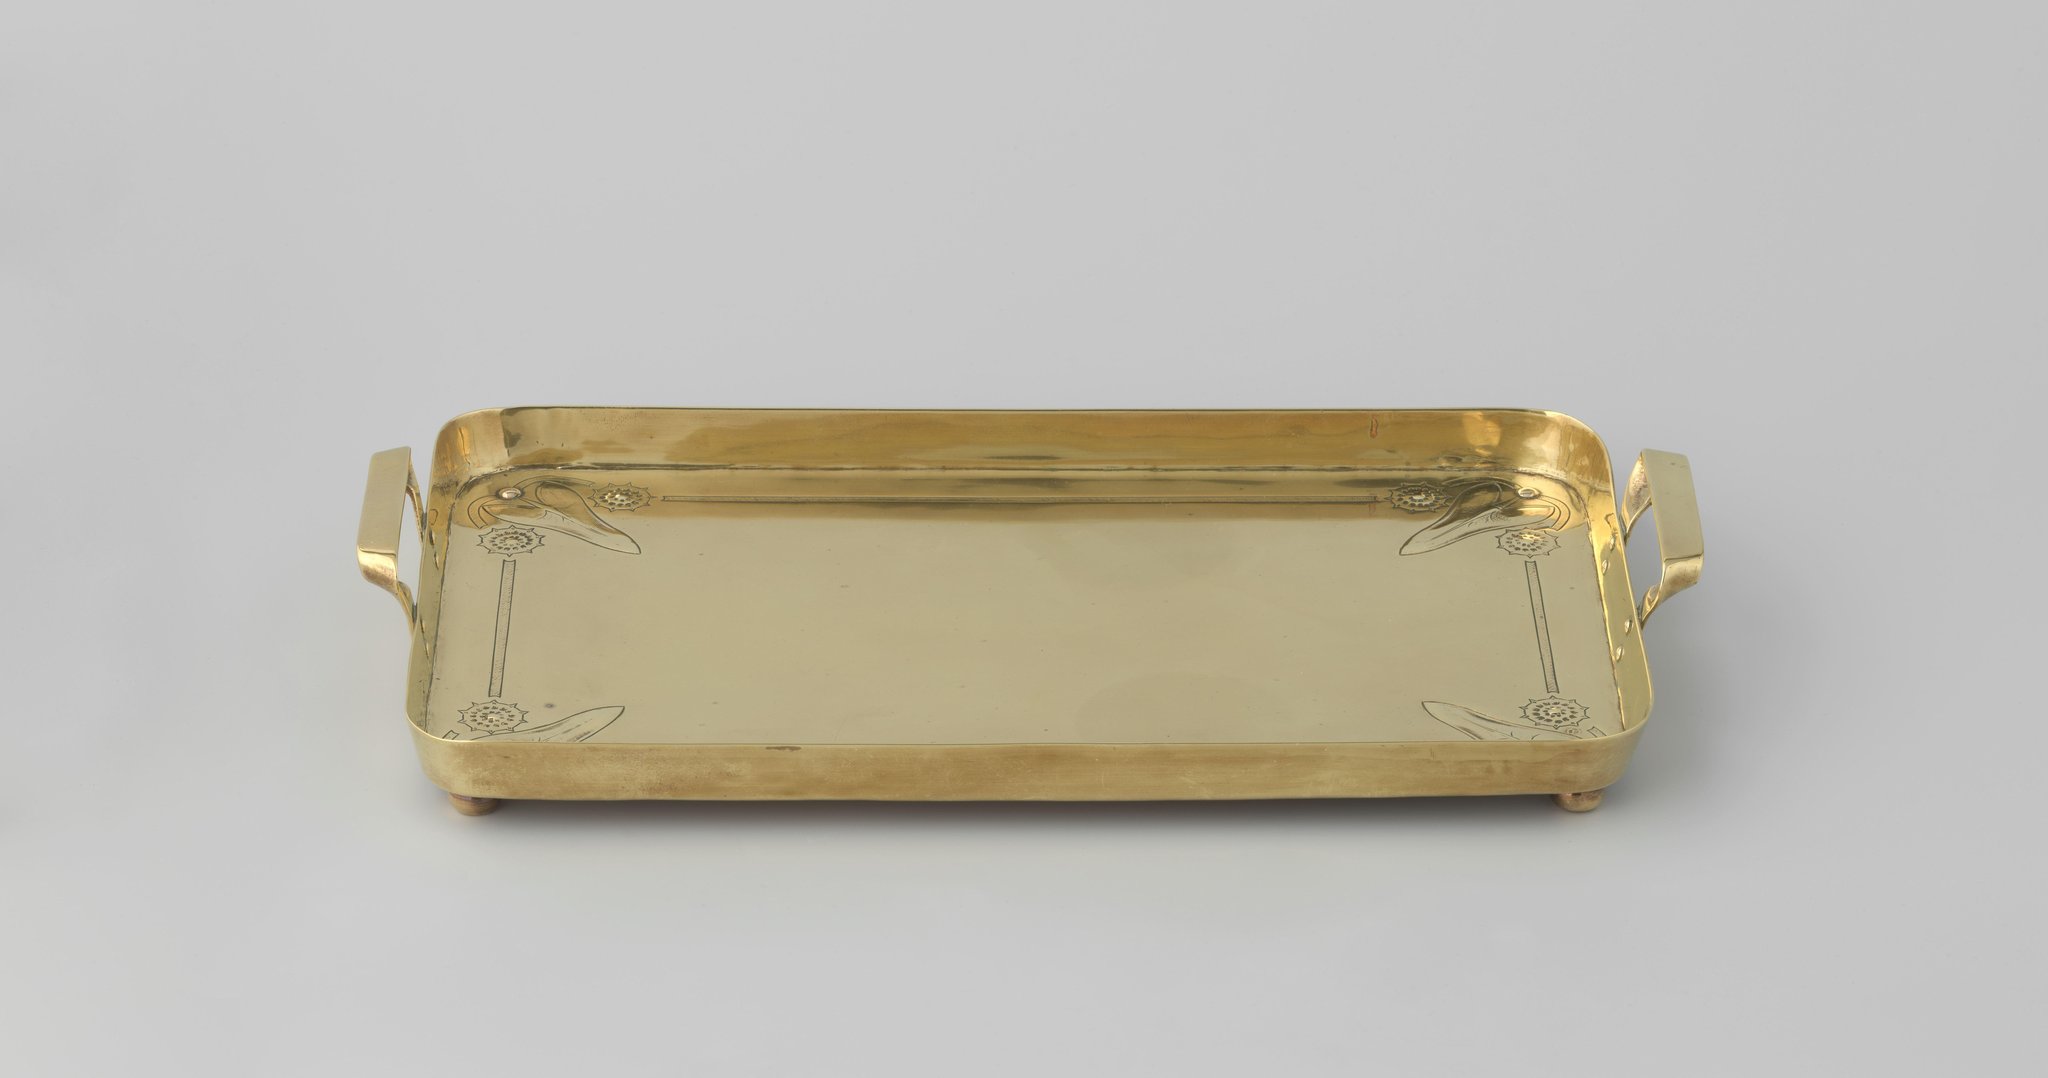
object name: salver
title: Presenteerblad van messing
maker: Anonymous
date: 1900-1910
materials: brass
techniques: metalworking, cutting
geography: netherlands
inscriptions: factory mark, factory mark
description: Presenteerblad van messing, behorende bij een theeservies. Het blad staat op vier ronde pootjes, is rechthoekig met ronde hoeken en heeft een recht opstaande rand. Aan beide korte zijden is een handvast dat aan de bovenzijde plat is, bevestigd met vier klinknagels. De bodembplaat is versierd met bloem- en rankmotieven in de hoeken